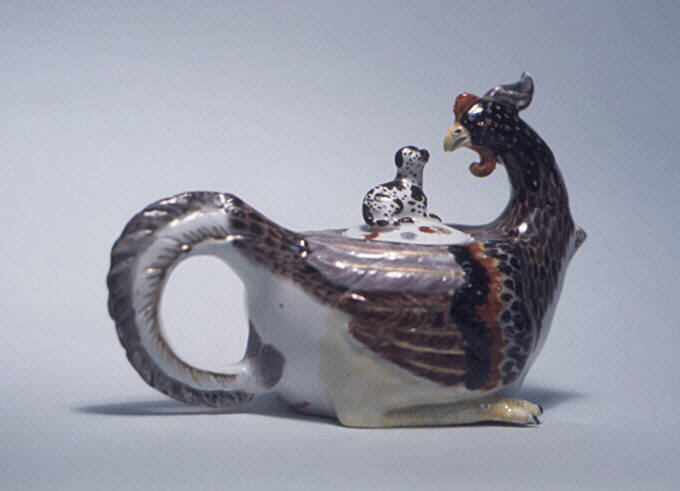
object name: teapot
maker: meissen manufactory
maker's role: manufactory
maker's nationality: german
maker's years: 1710-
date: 1734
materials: hard paste porcelain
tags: roosters,dogs